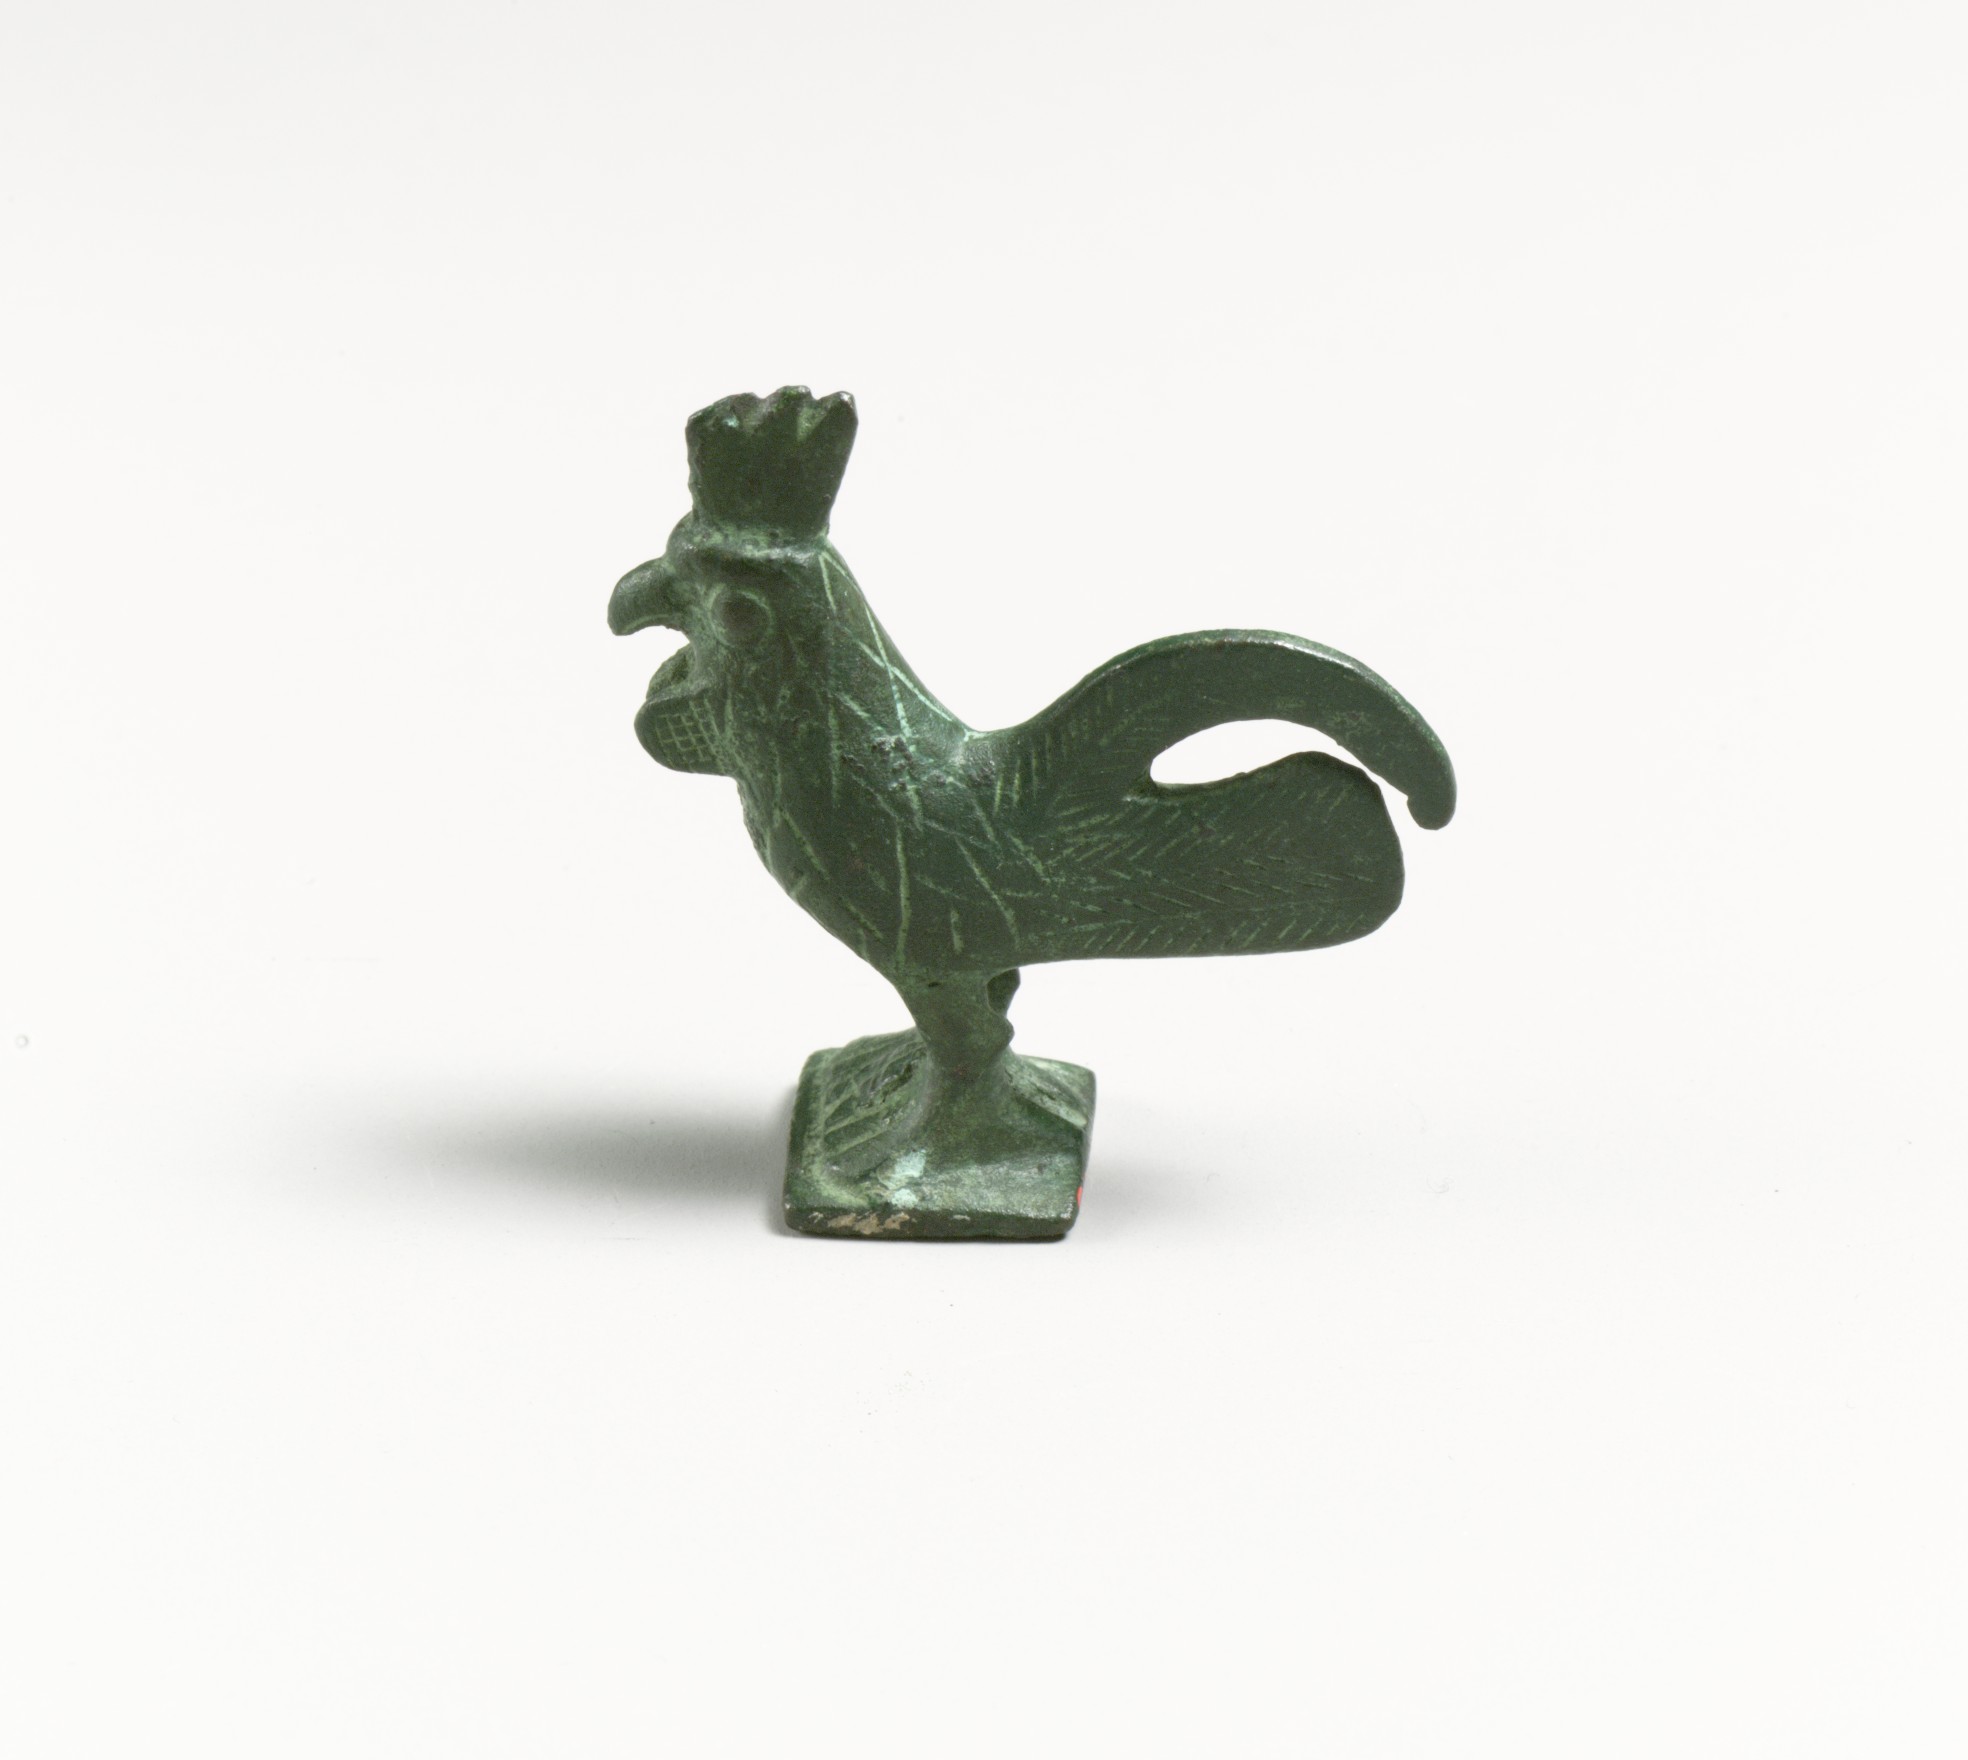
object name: statuette of a rooster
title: Bronze statuette of a rooster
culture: cypriot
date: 600-501 BCE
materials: bronze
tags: roosters